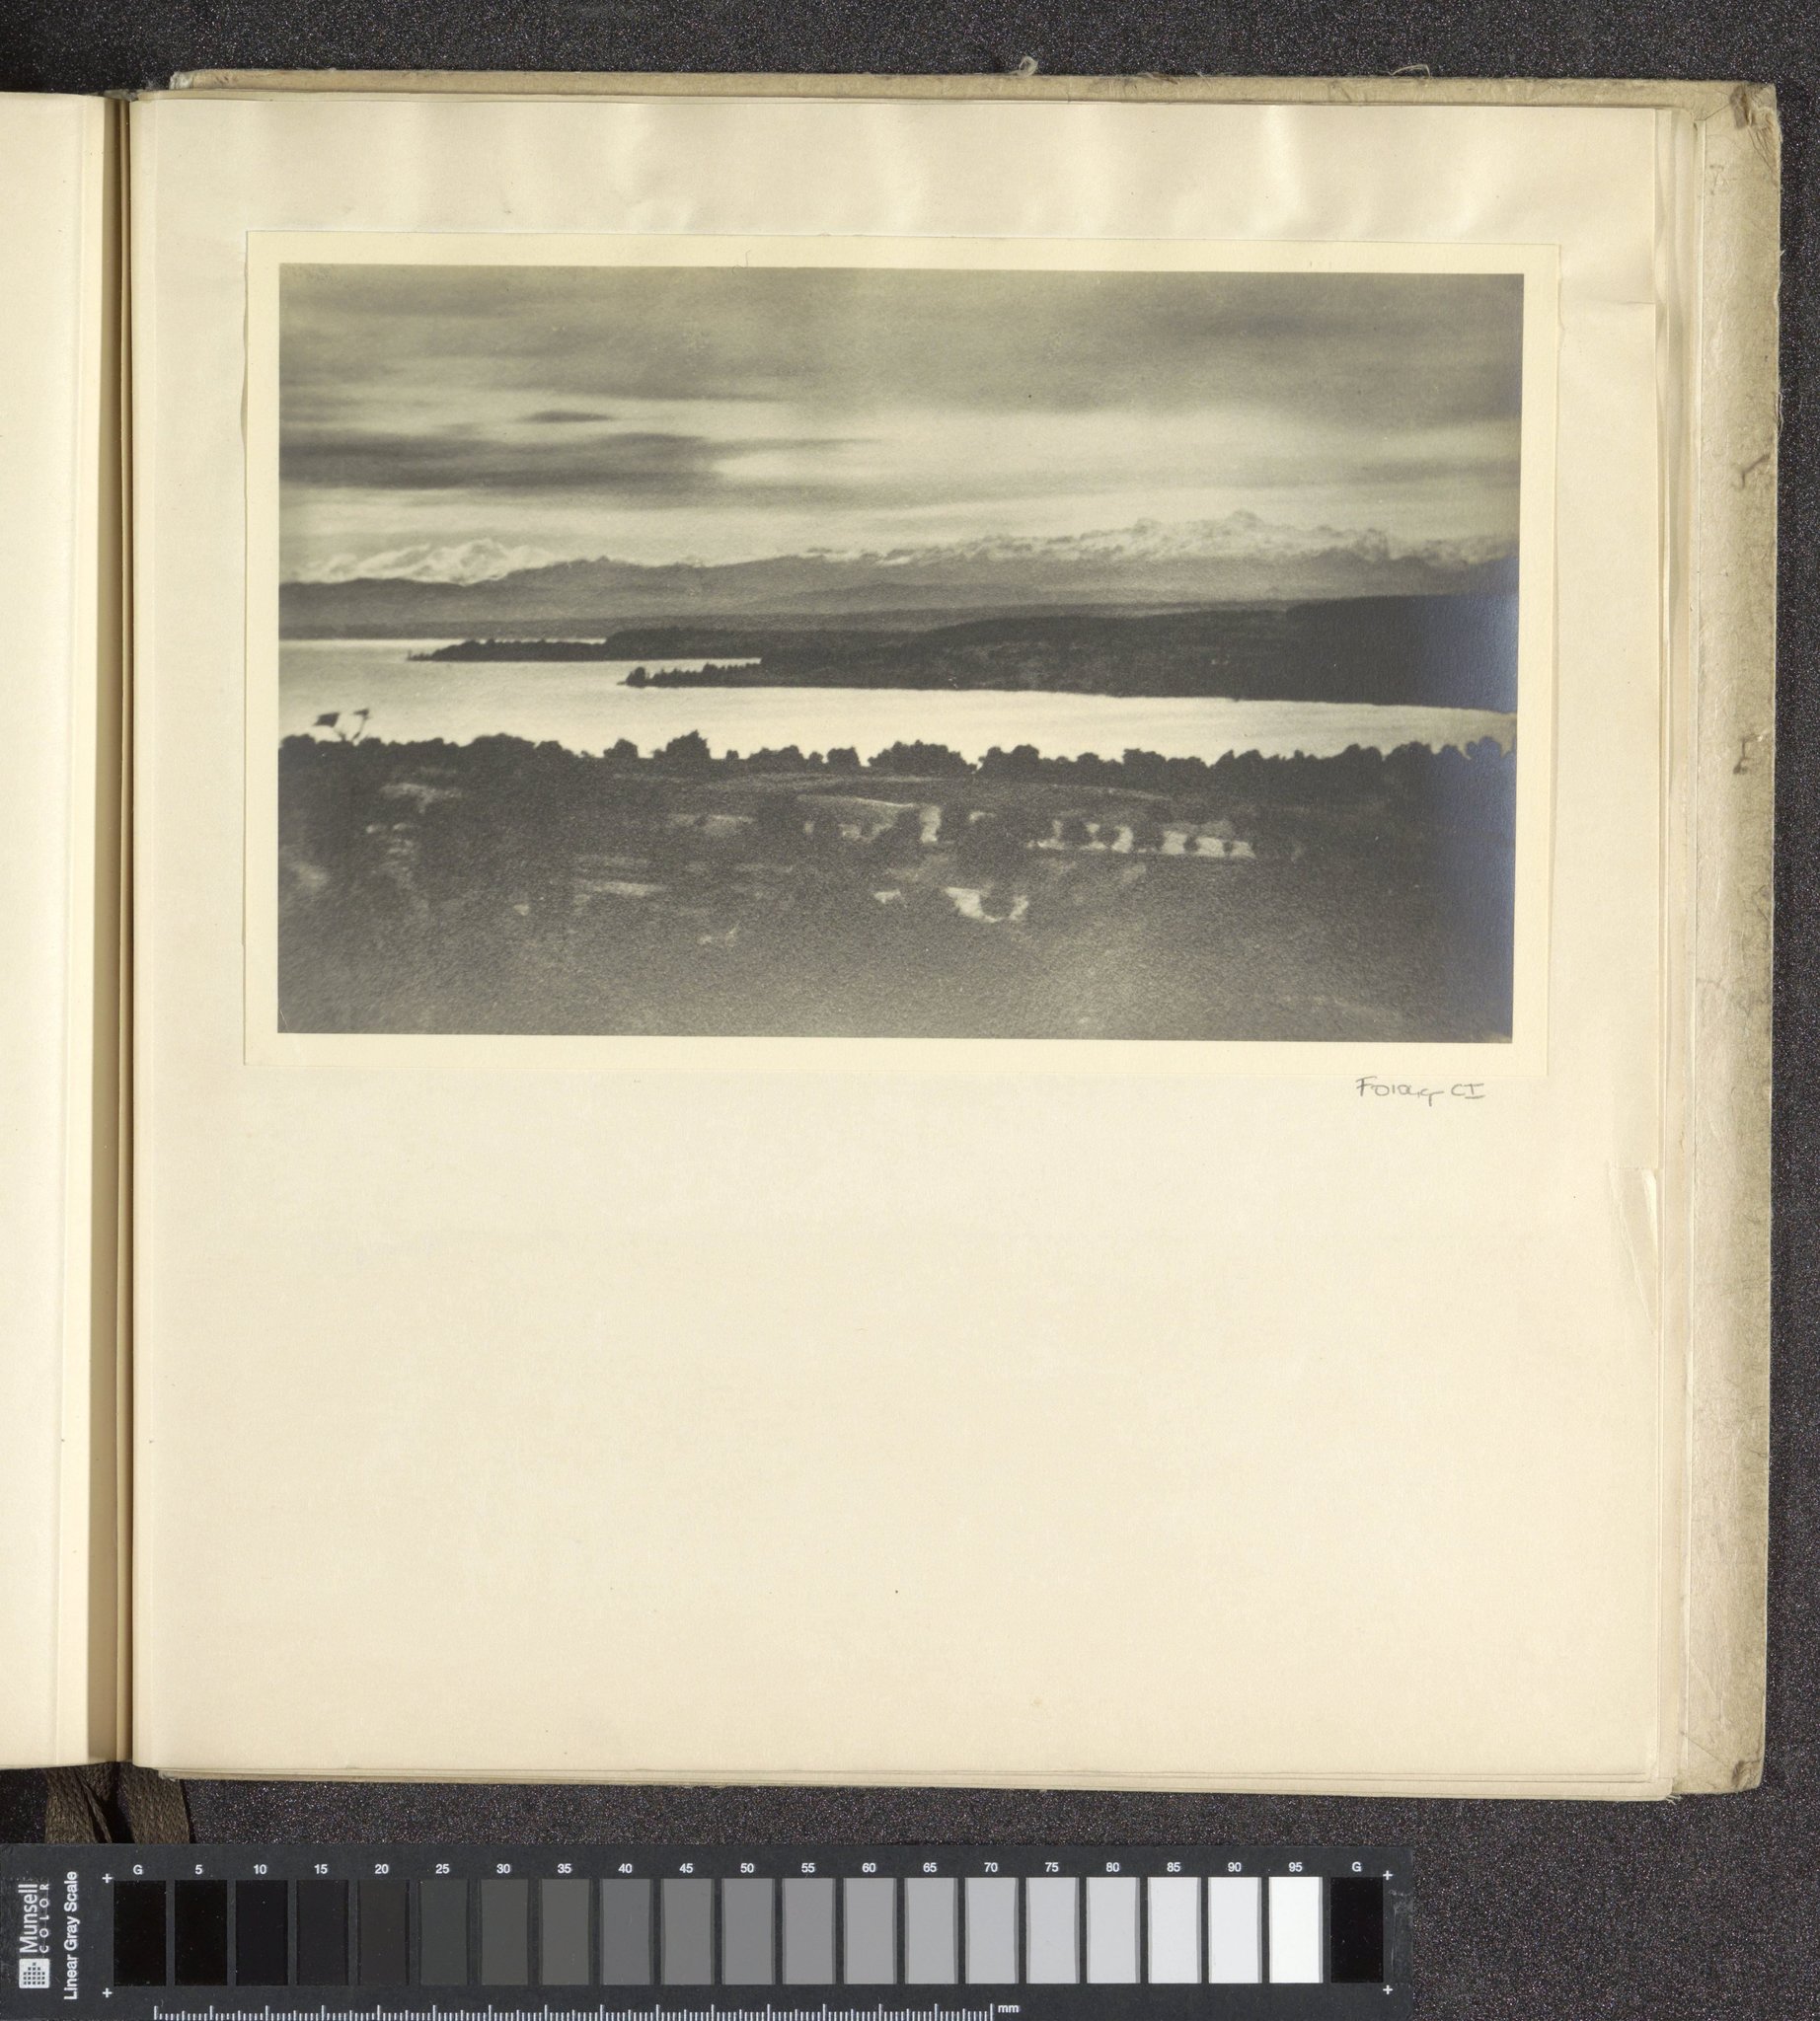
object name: photograph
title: Landschap rond het Bodenmeer ter hoogte van Schloss Spetzgart, nevenvestiging van Schule Schloss Salem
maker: Anonymous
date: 1929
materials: photographic support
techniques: gelatin silver print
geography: uberlingen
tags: lake, education, mountains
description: Onderdeel van Fotoalbum van Schule Schloss Salem.